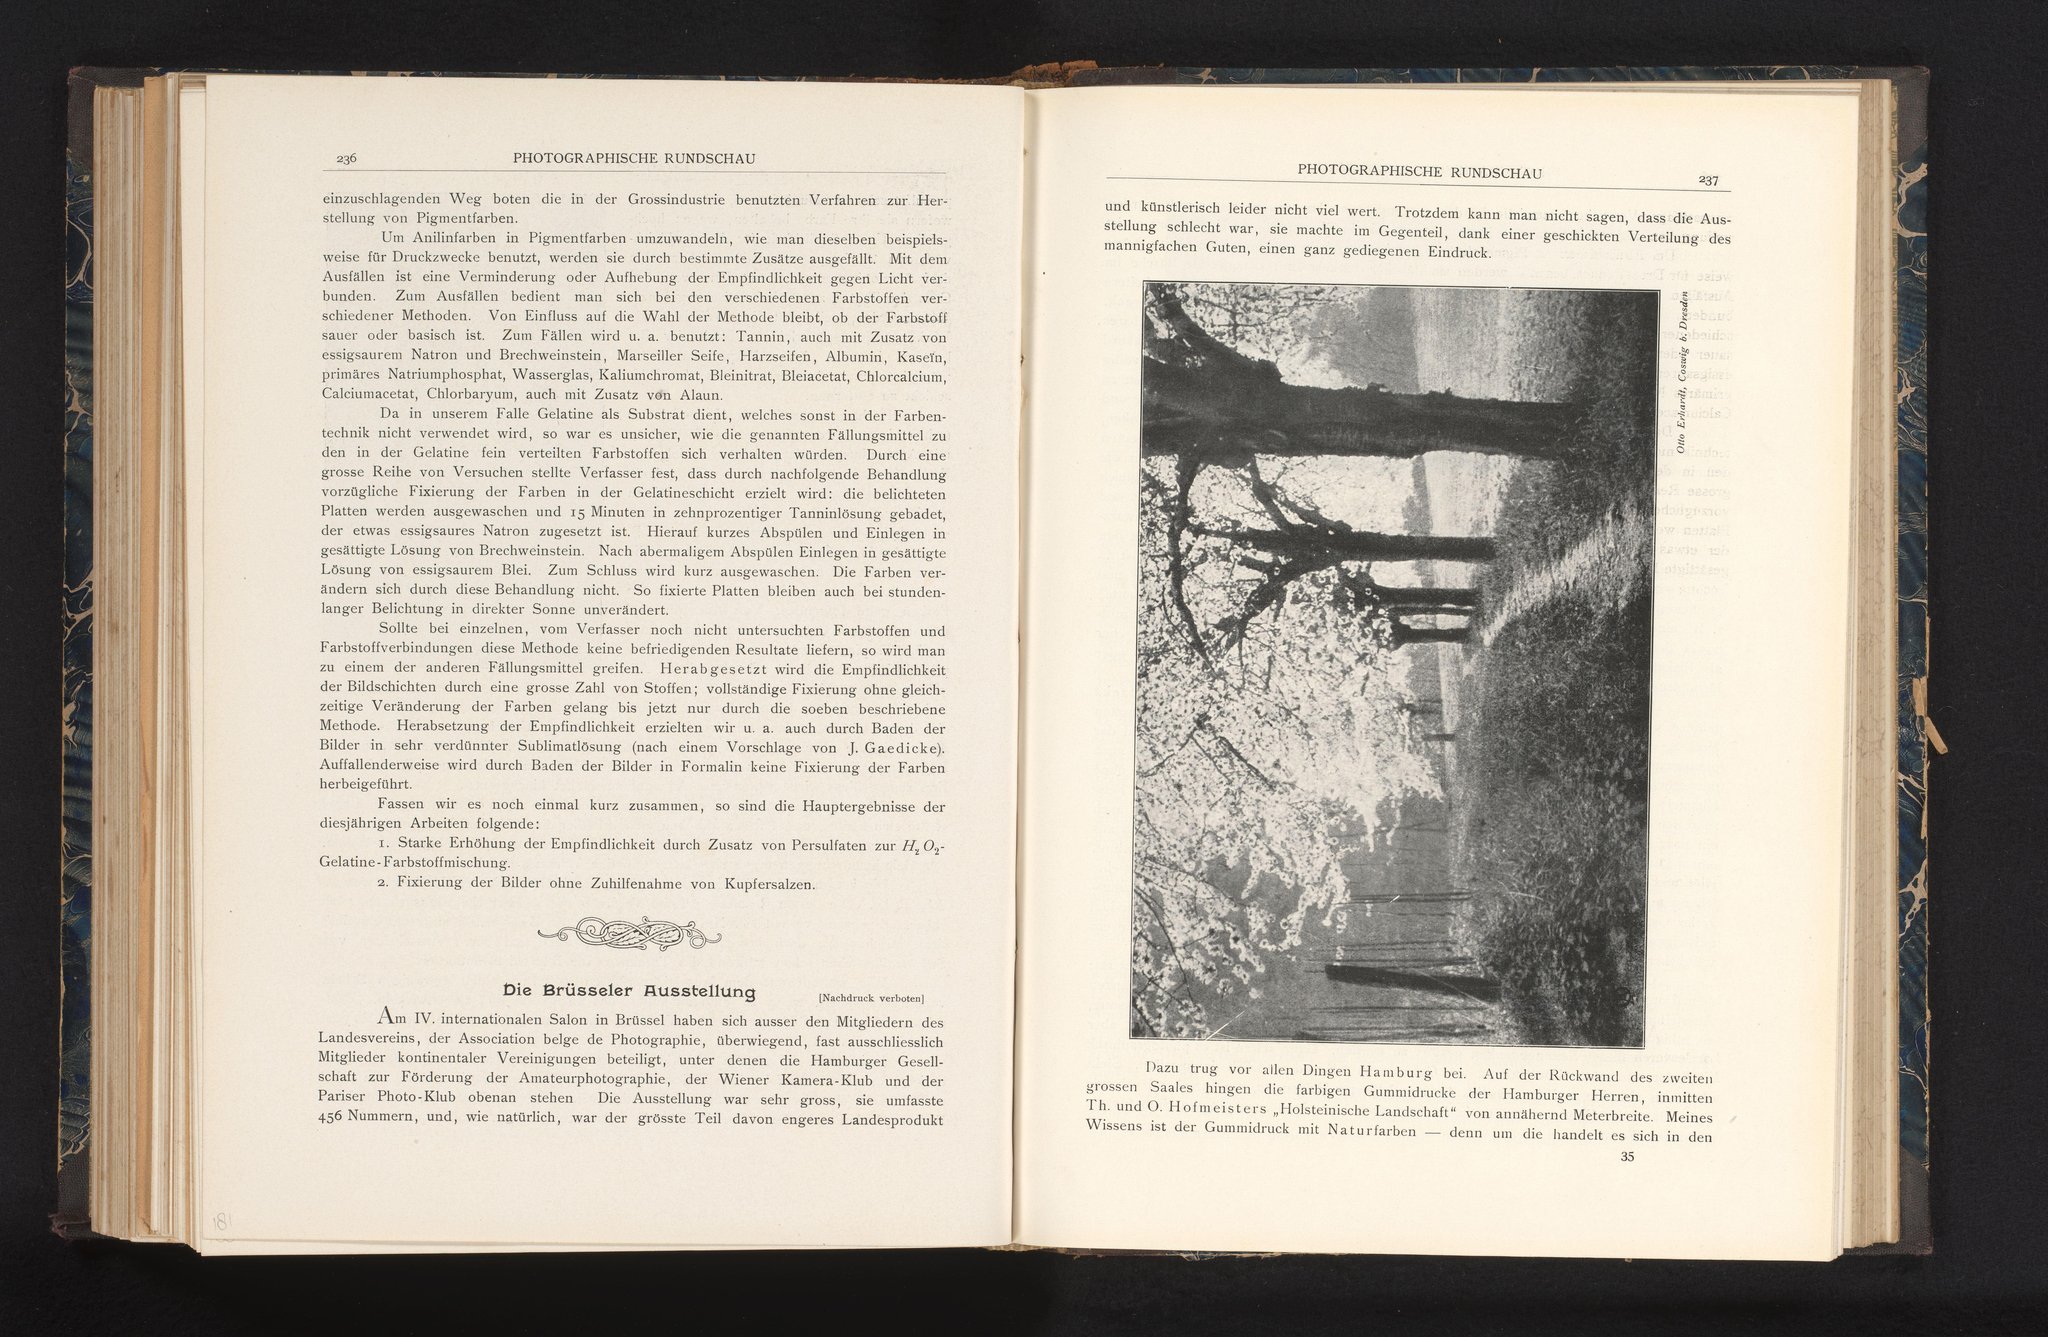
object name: page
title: Gezicht op een aantal bomen in bloei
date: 1897-1902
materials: paper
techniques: autotype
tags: trees